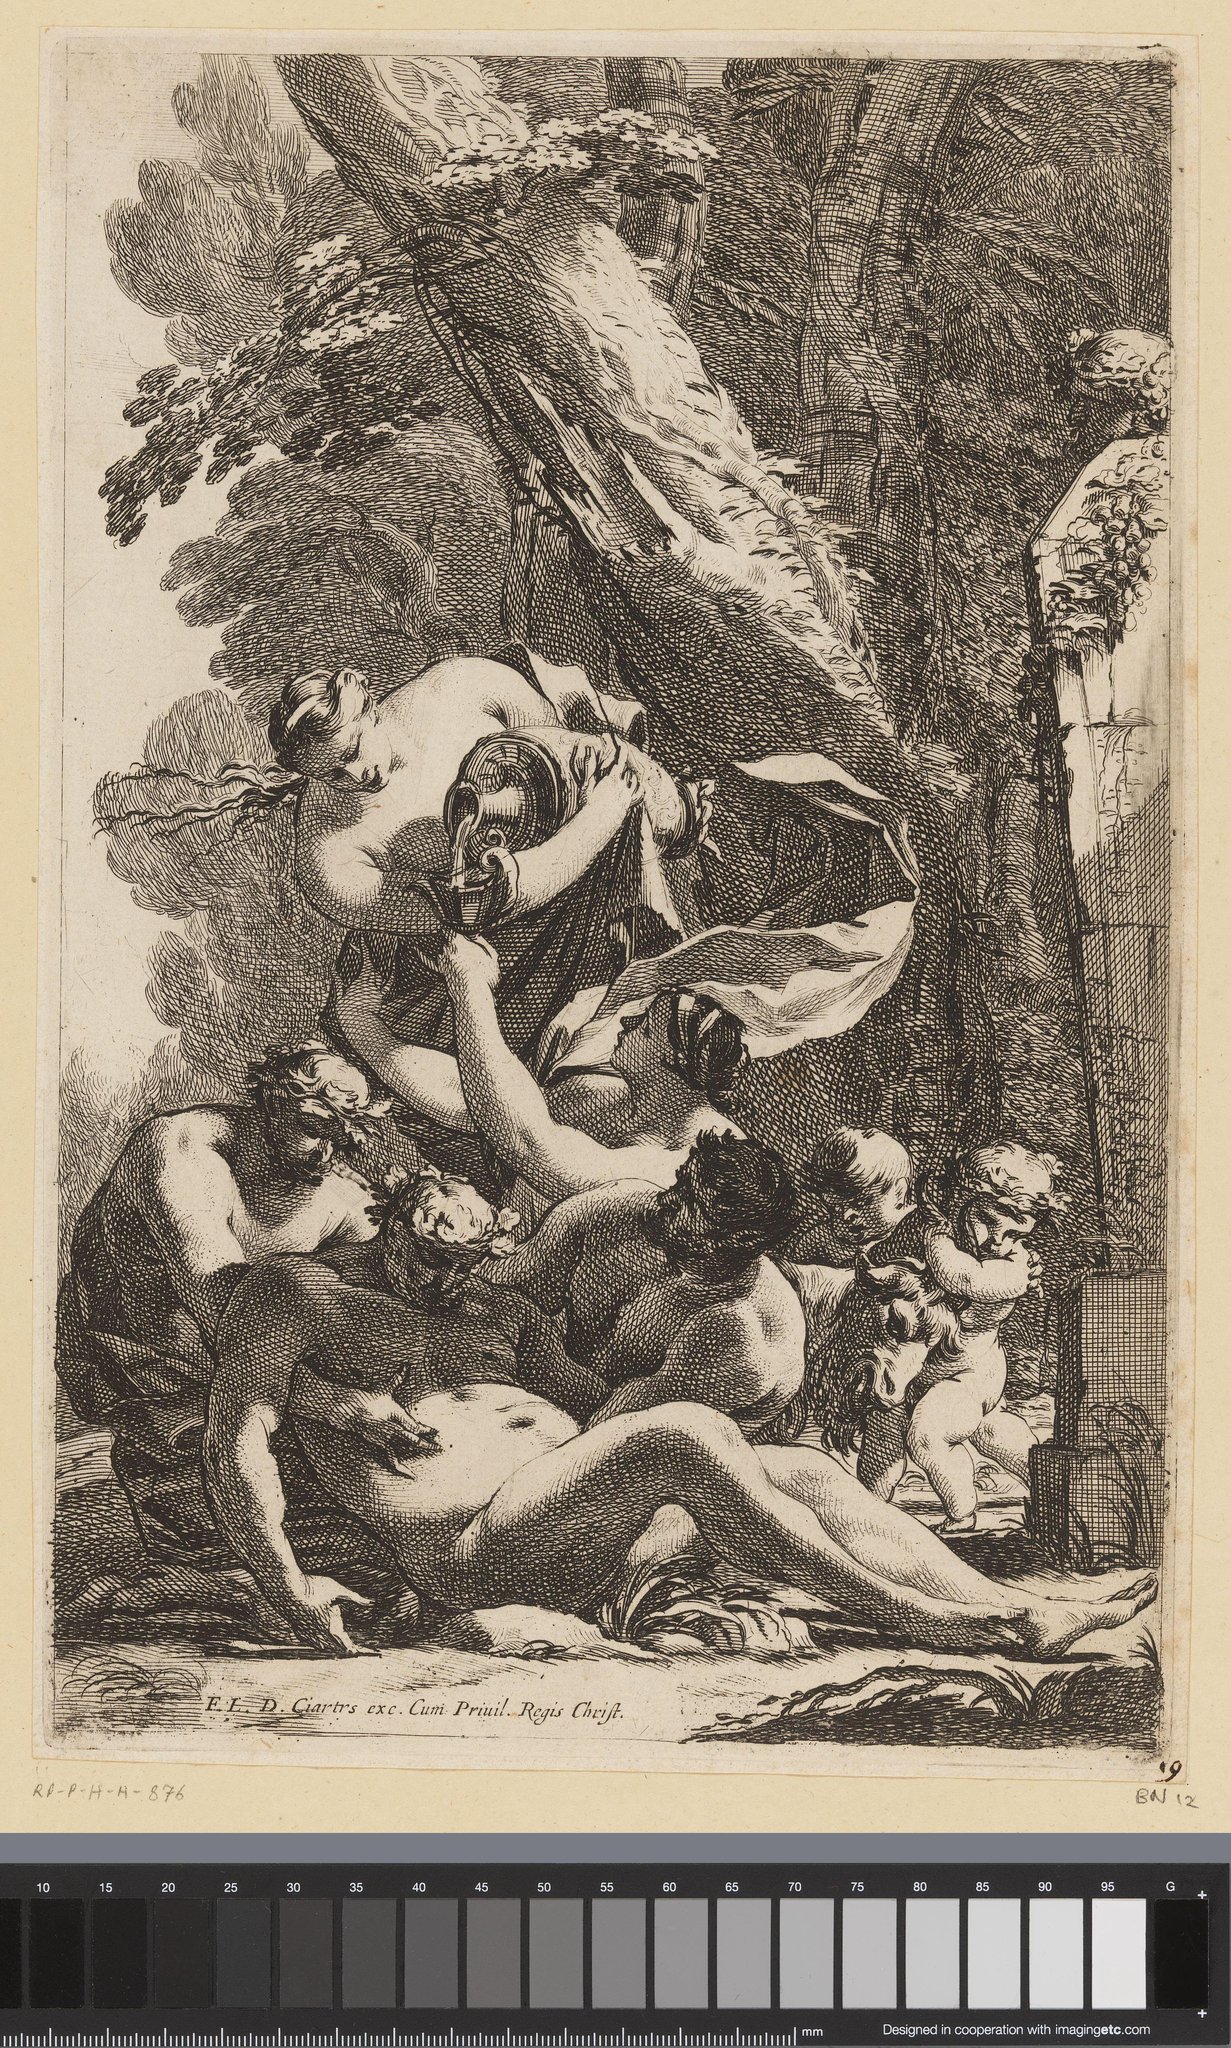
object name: print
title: Bacchanalen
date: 1626-1647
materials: paper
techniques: engraving, etching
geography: france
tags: (story of) silenus, drinking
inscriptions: collector's mark: Lugt 11